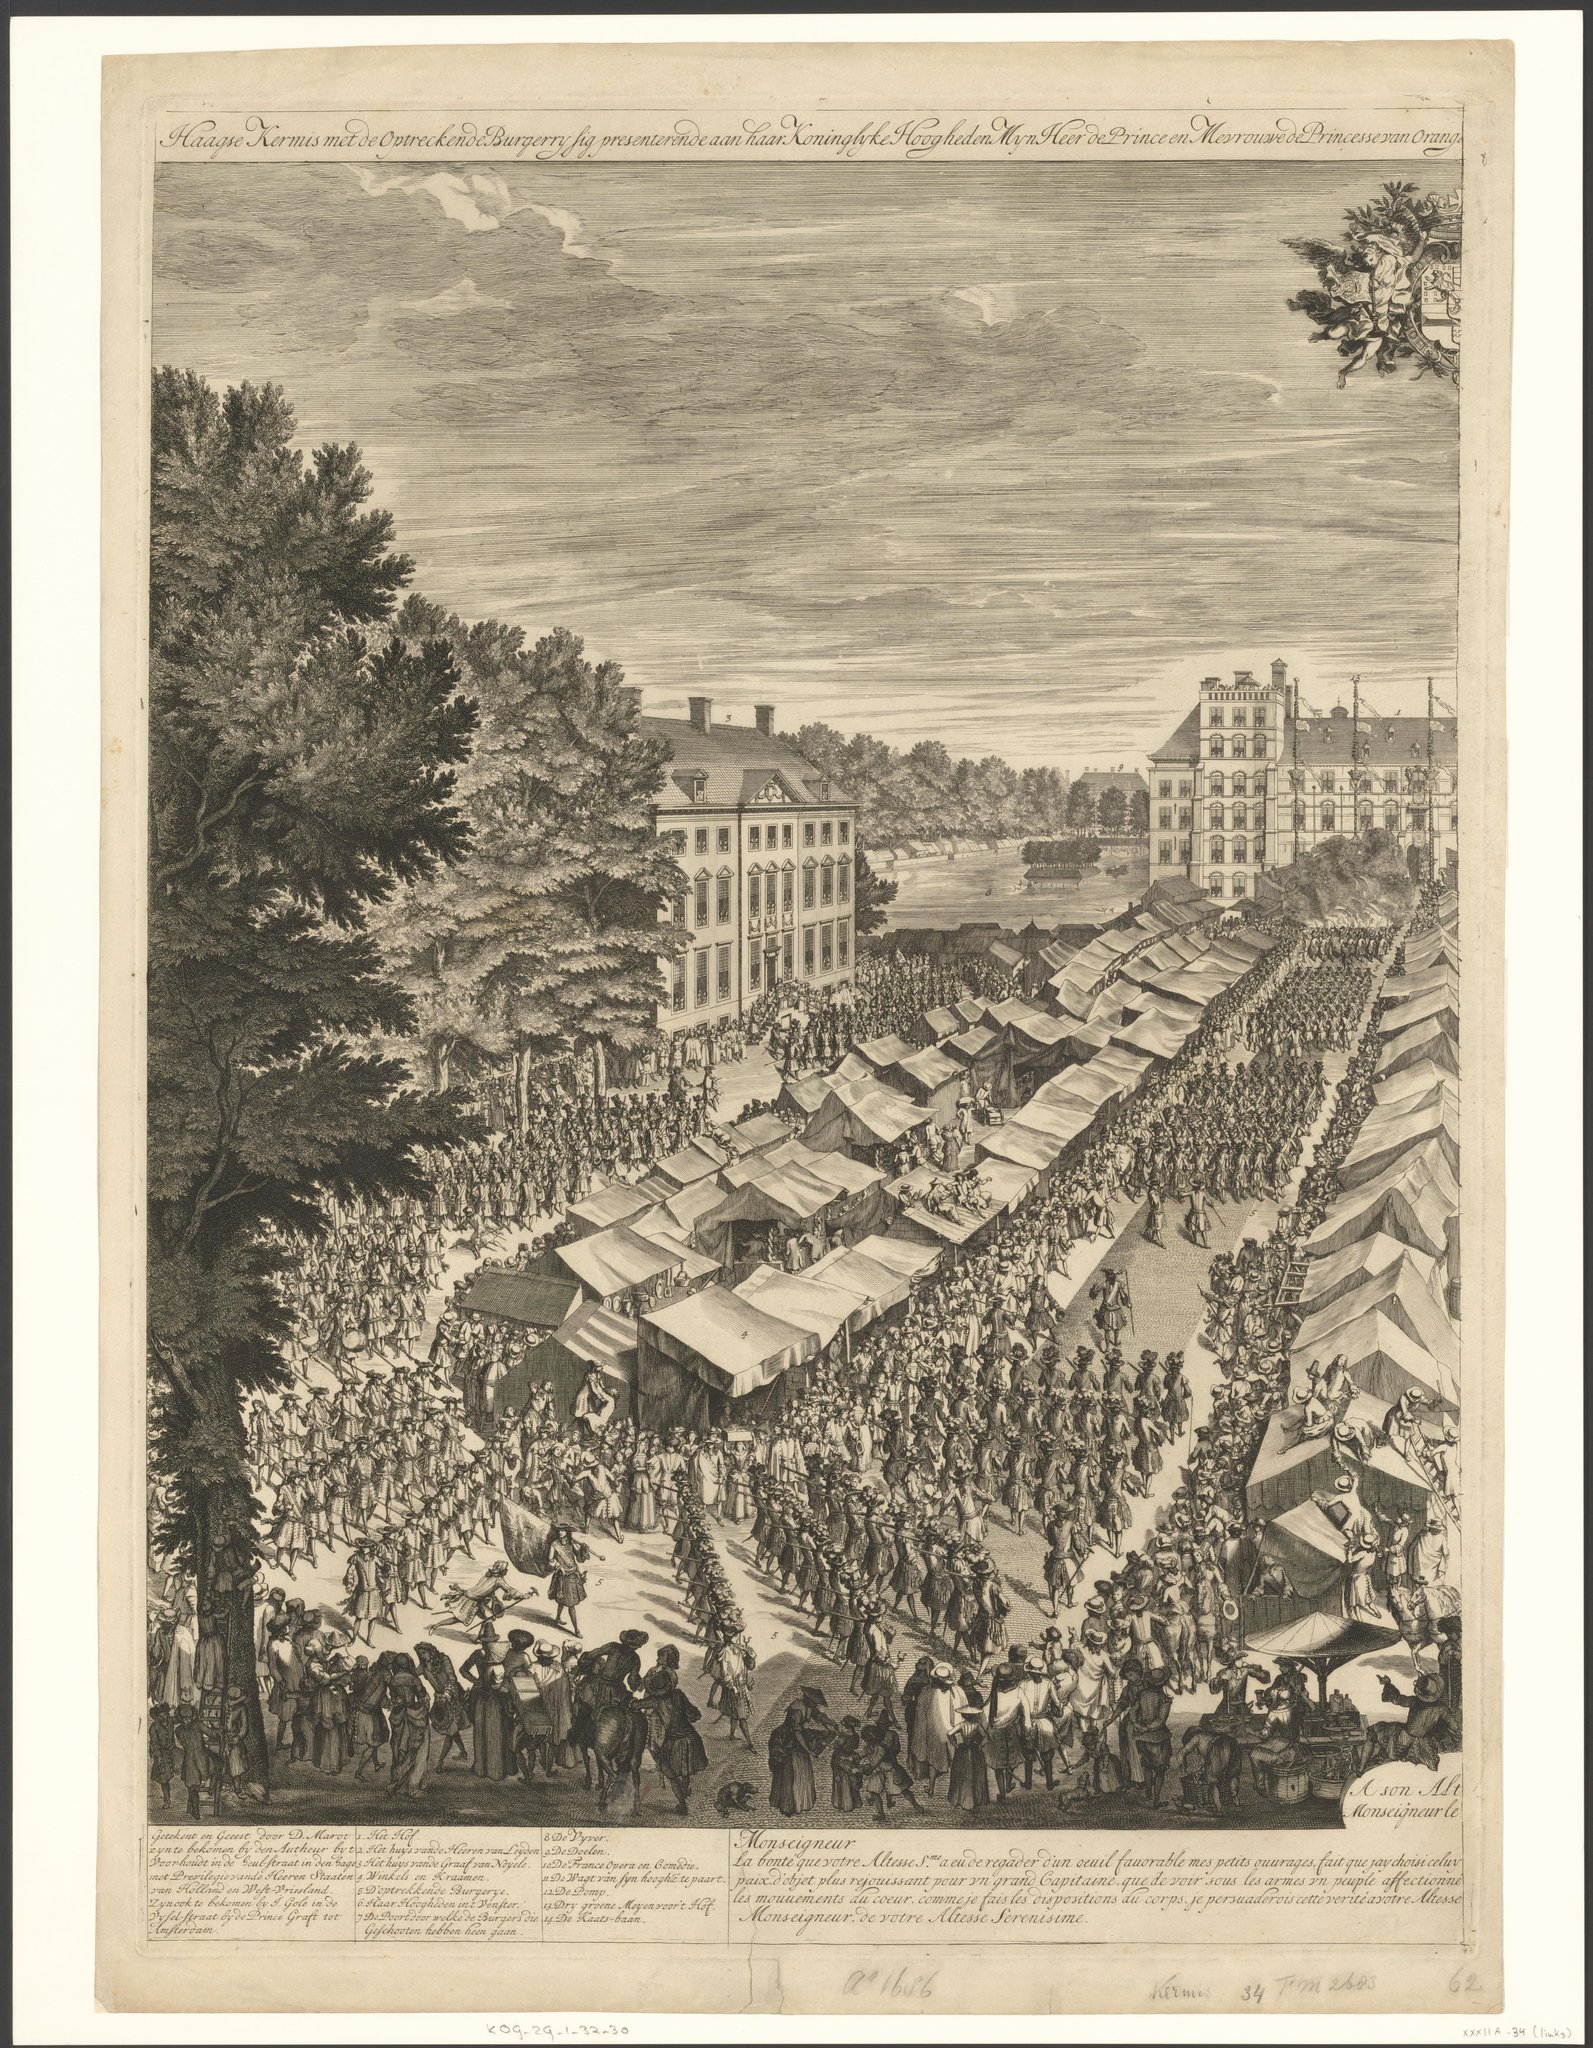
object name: print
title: Haagse Kermis met de prins en prinses van Oranje, 1686 (linkerblad)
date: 1686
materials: paper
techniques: engraving, etching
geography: amsterdam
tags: william iii (prince of orange and king of england, scotland, and ireland), london, maria ii stuart (koningin van engeland, schotland en ierland), (annual) fair, trade fair, pleasure fair and circus, market, armorial bearing, heraldry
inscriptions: collector's mark: Lugt 963, collector's mark: Lugt 1641, collector's mark:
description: Linkerblad van een prent van de Haagse Kermis met de prins en prinses van Oranje, 1686. Haagse kermis in 1686 gehouden op het Buitenhof, met de paraderende schutterij vanaf het Noyelleshuis (later Vijverhof) links tussen de kramen over de markt tot aan de poort waar saluutschoten worden gebracht voor het prinselijk paar dat vanuit het raam in het Stadhouderlijk Kwartier toekijkt. Rechts staat de wacht van de prins te paard opgesteld voor de Kaatsbaan en de Komedie. In de lucht twee engelen met het prinselijke wapen van Willem III. Onderaan de opdracht in 4 regels in het Frans en de legenda's 1-14 in het Nederlands en Frans. Onderwerpsrubrieken binnen de Atlas Zeden en Gewoonten: Volksfeesten; Kermis.